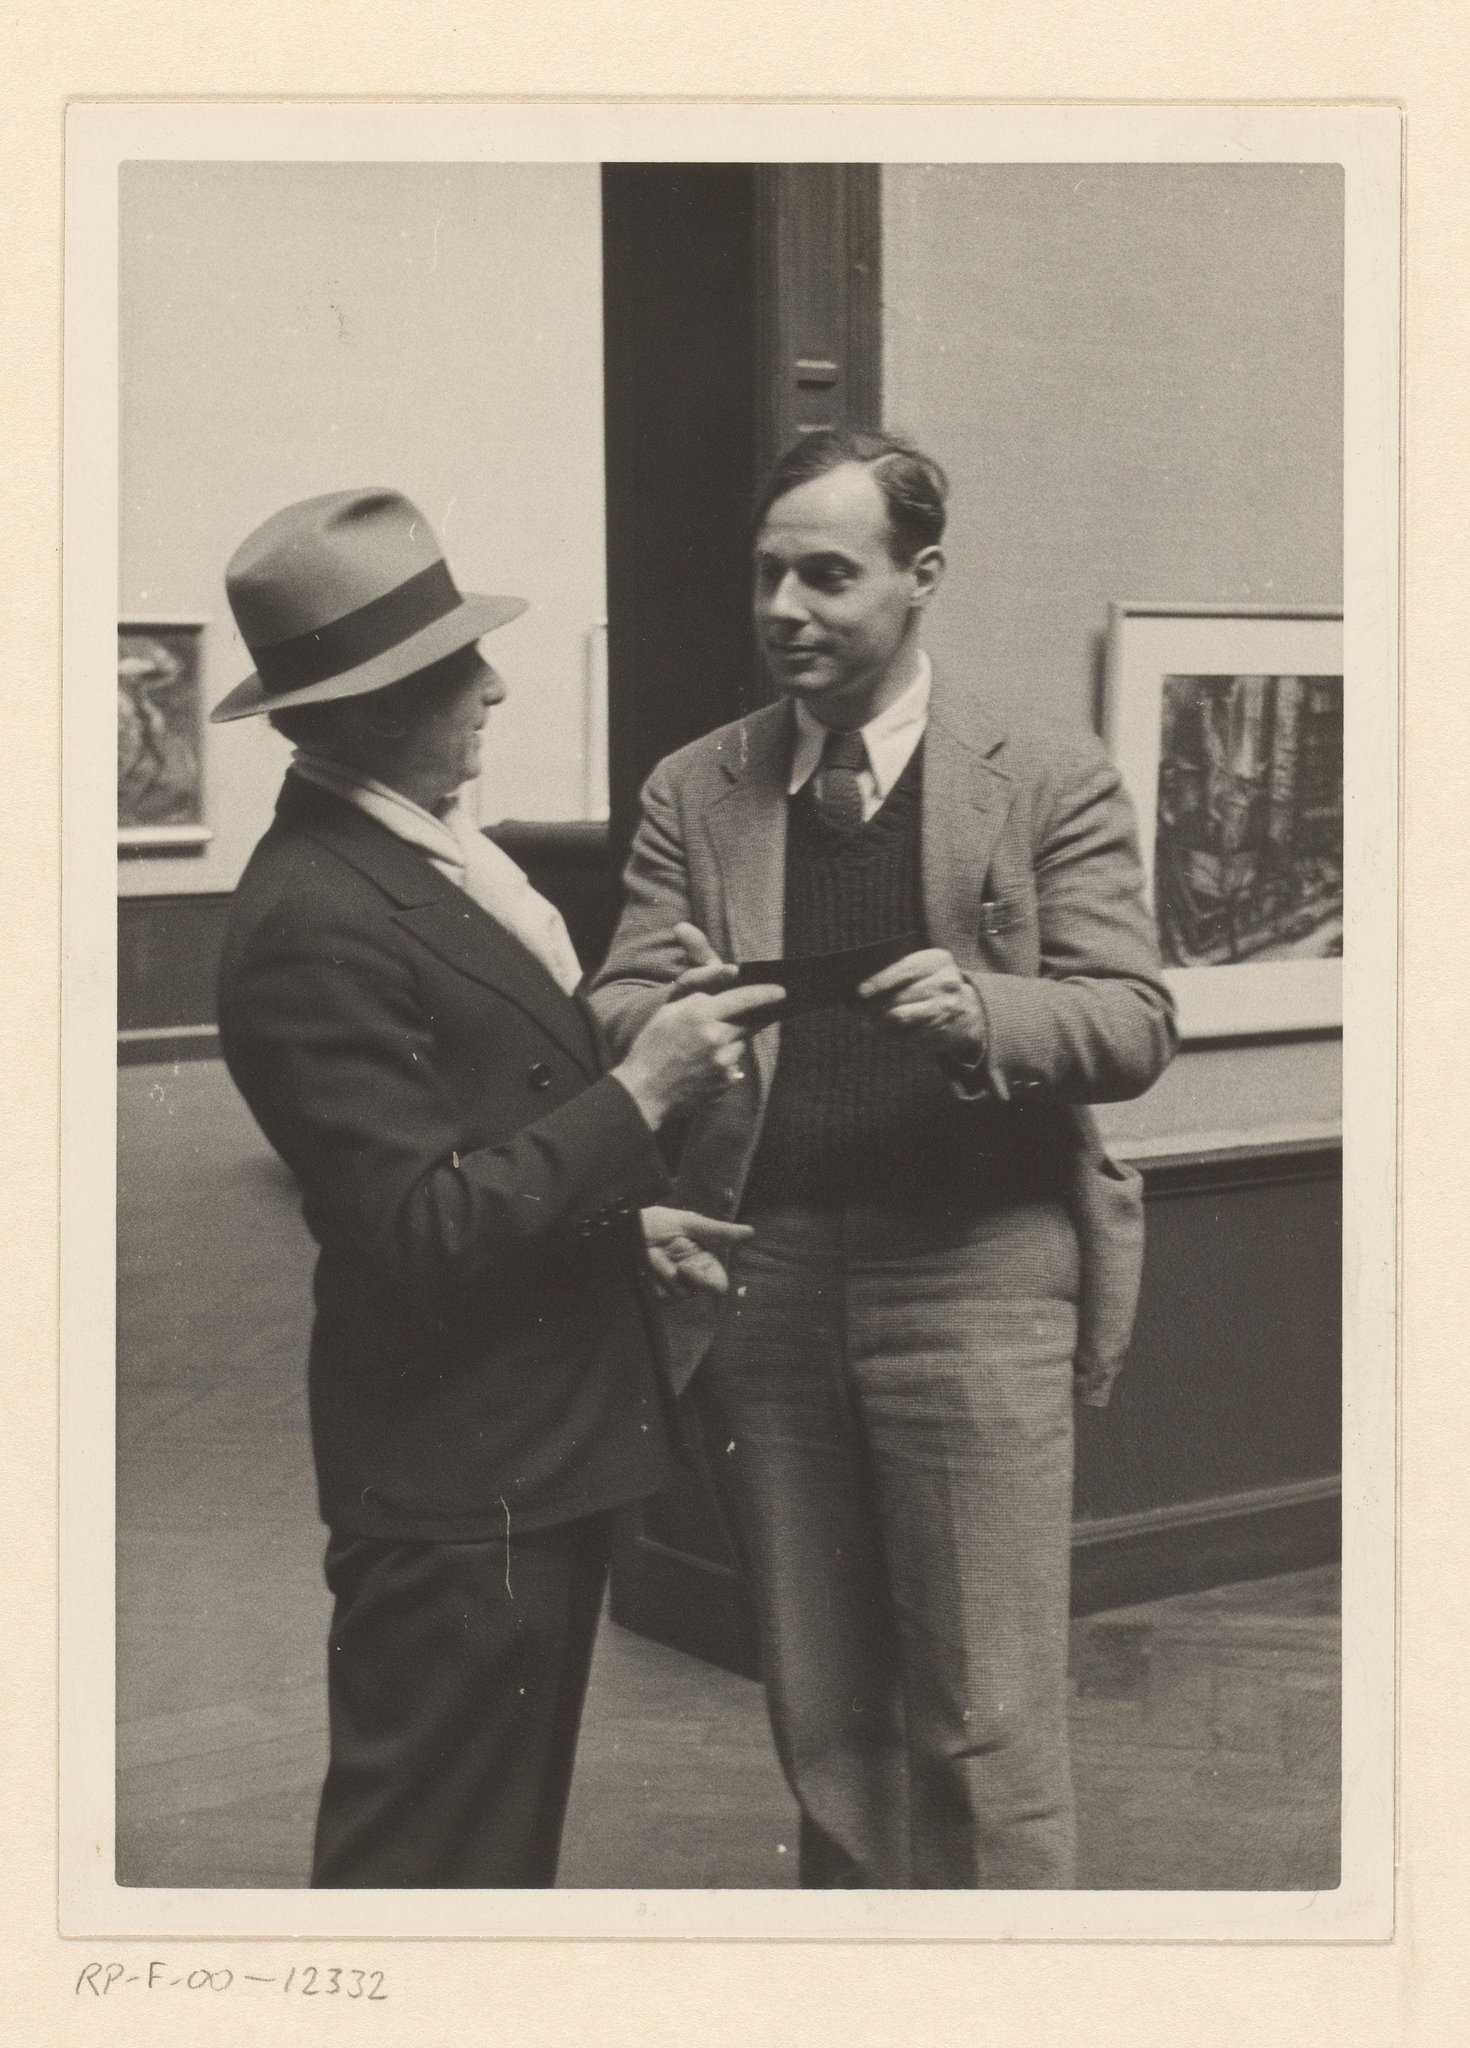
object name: photograph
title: Gerard Hordijk en Mommie Schwarz in een tentoonstellingsruimte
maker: Anonymous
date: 1935-1940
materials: paper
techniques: gelatin silver print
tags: print maker, mommie schwarz, the hague, amsterdam, draughtsman, gerard hordijk, historical persons